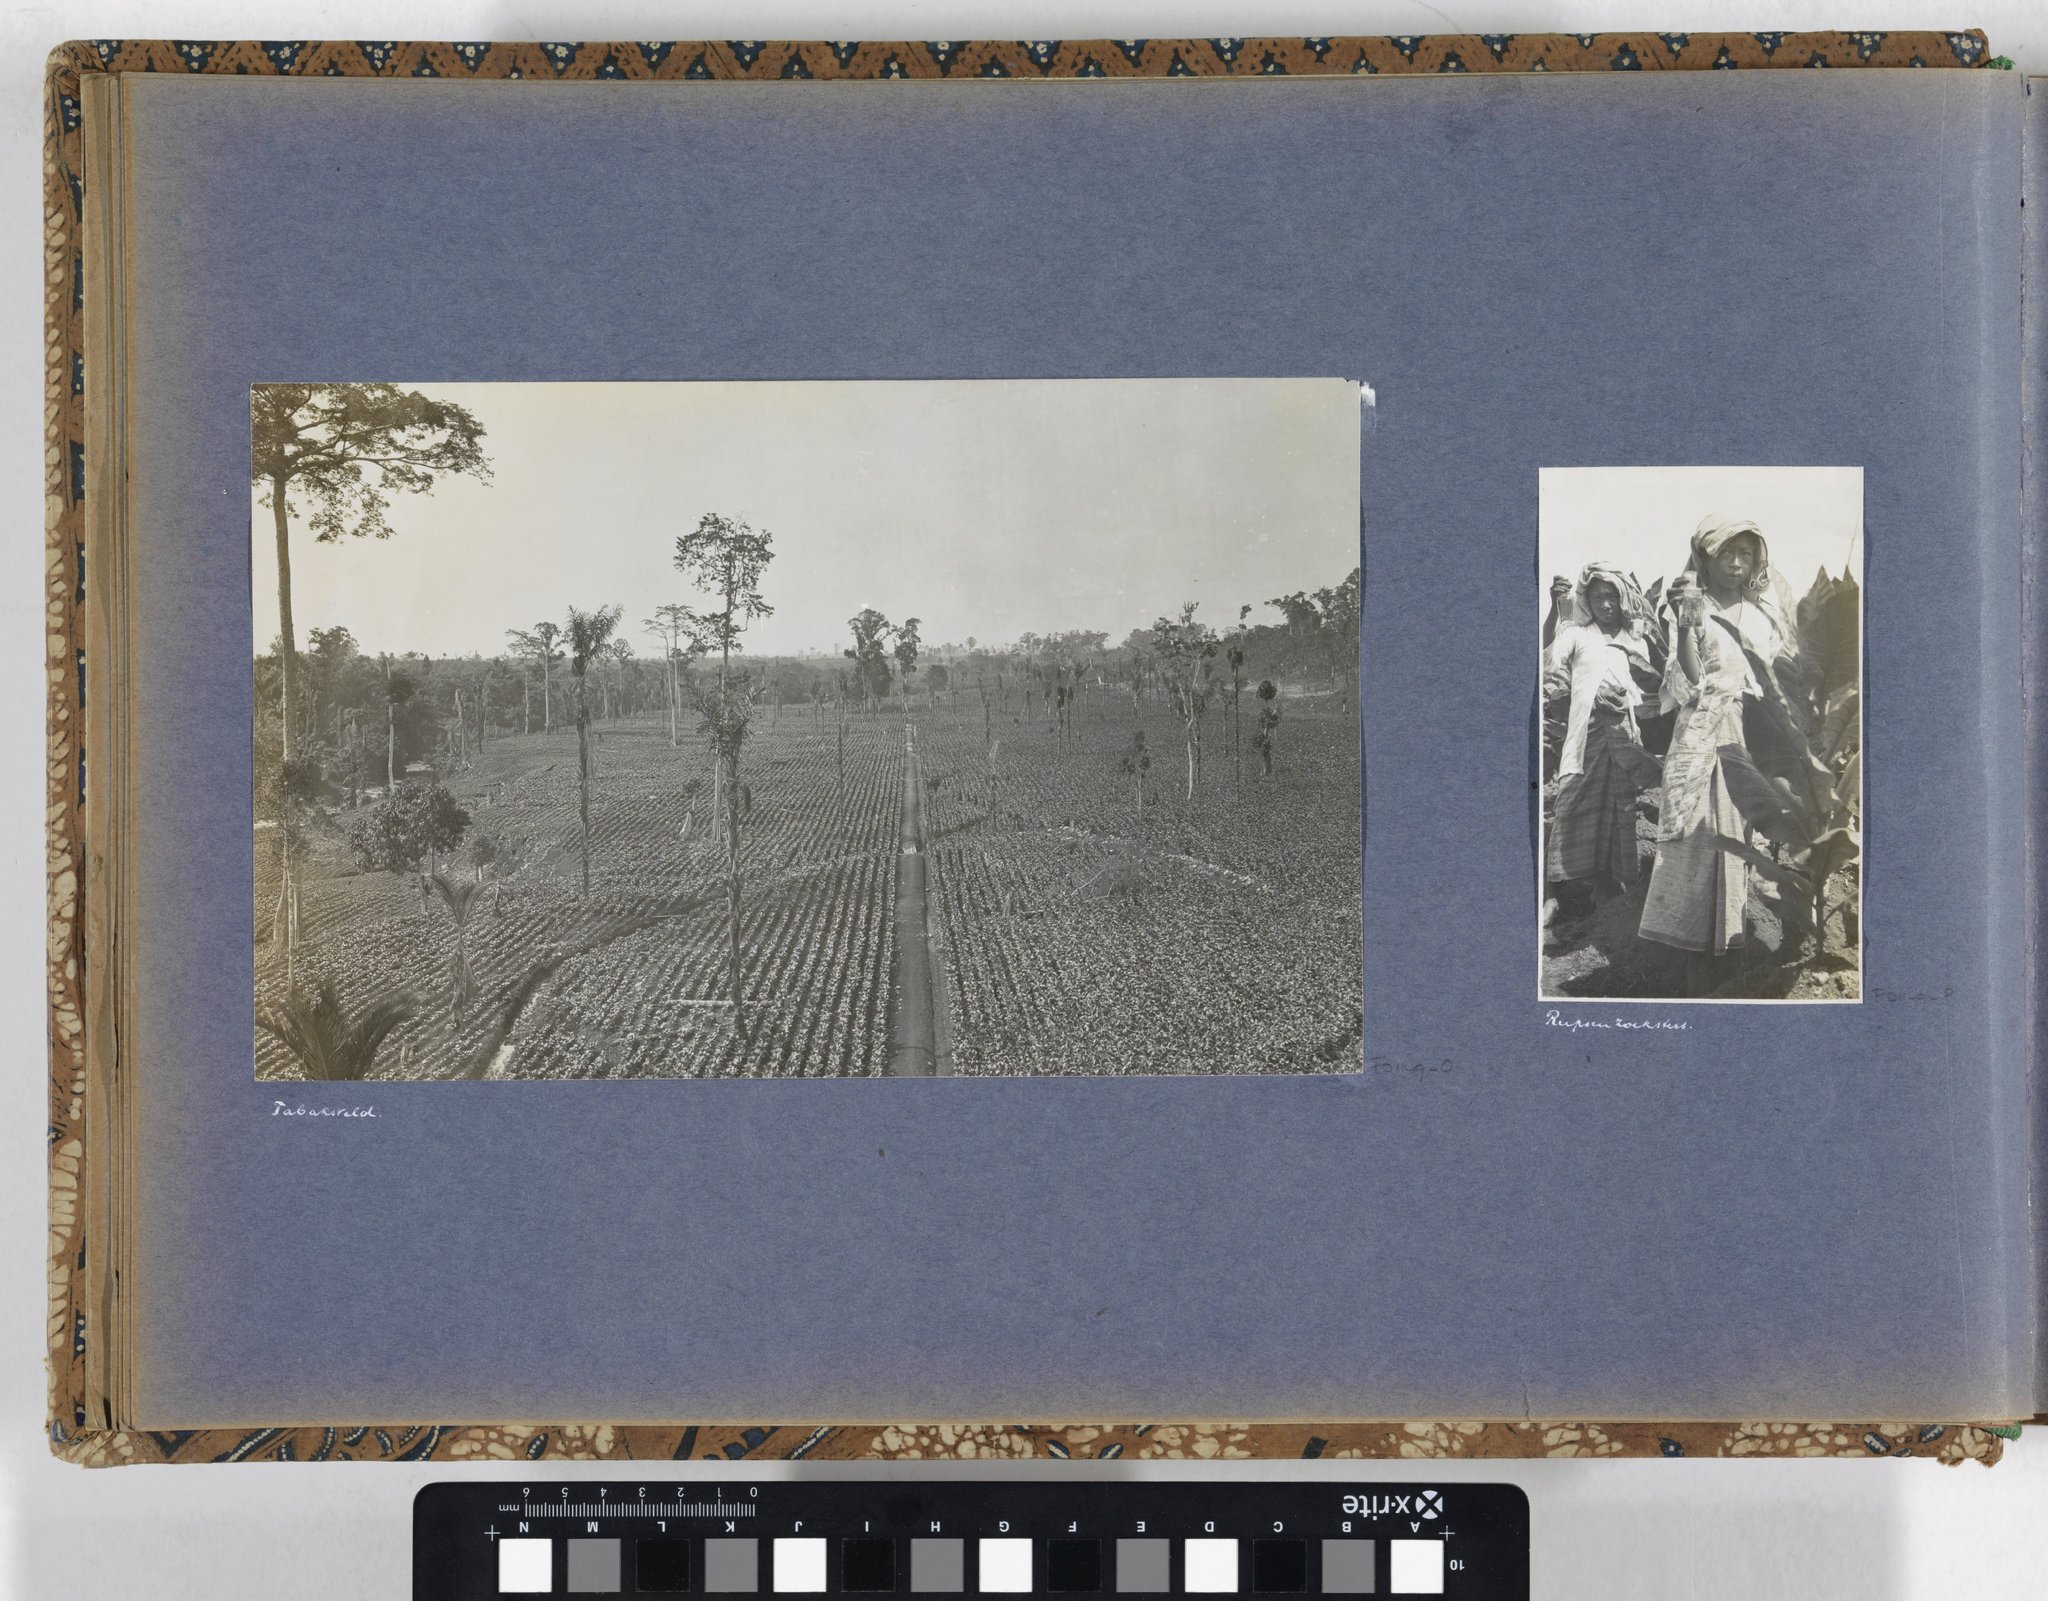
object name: photograph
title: Twee Indische rupsenzoeksters tonen vangst op plantage op Sumatra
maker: Anonymous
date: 1900-1920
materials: paper, photographic support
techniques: gelatin silver print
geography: sumatra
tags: plantation, working class, labourers, catching animals, tobacco, sumatra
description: Mogelijk gaat het om contractarbeidersters. Onderdeel van reisalbum met foto's van bedrijvigheid en bezienswaardigheden op Sumatra en Java en van de reis naar en van Nederlands-Indië.